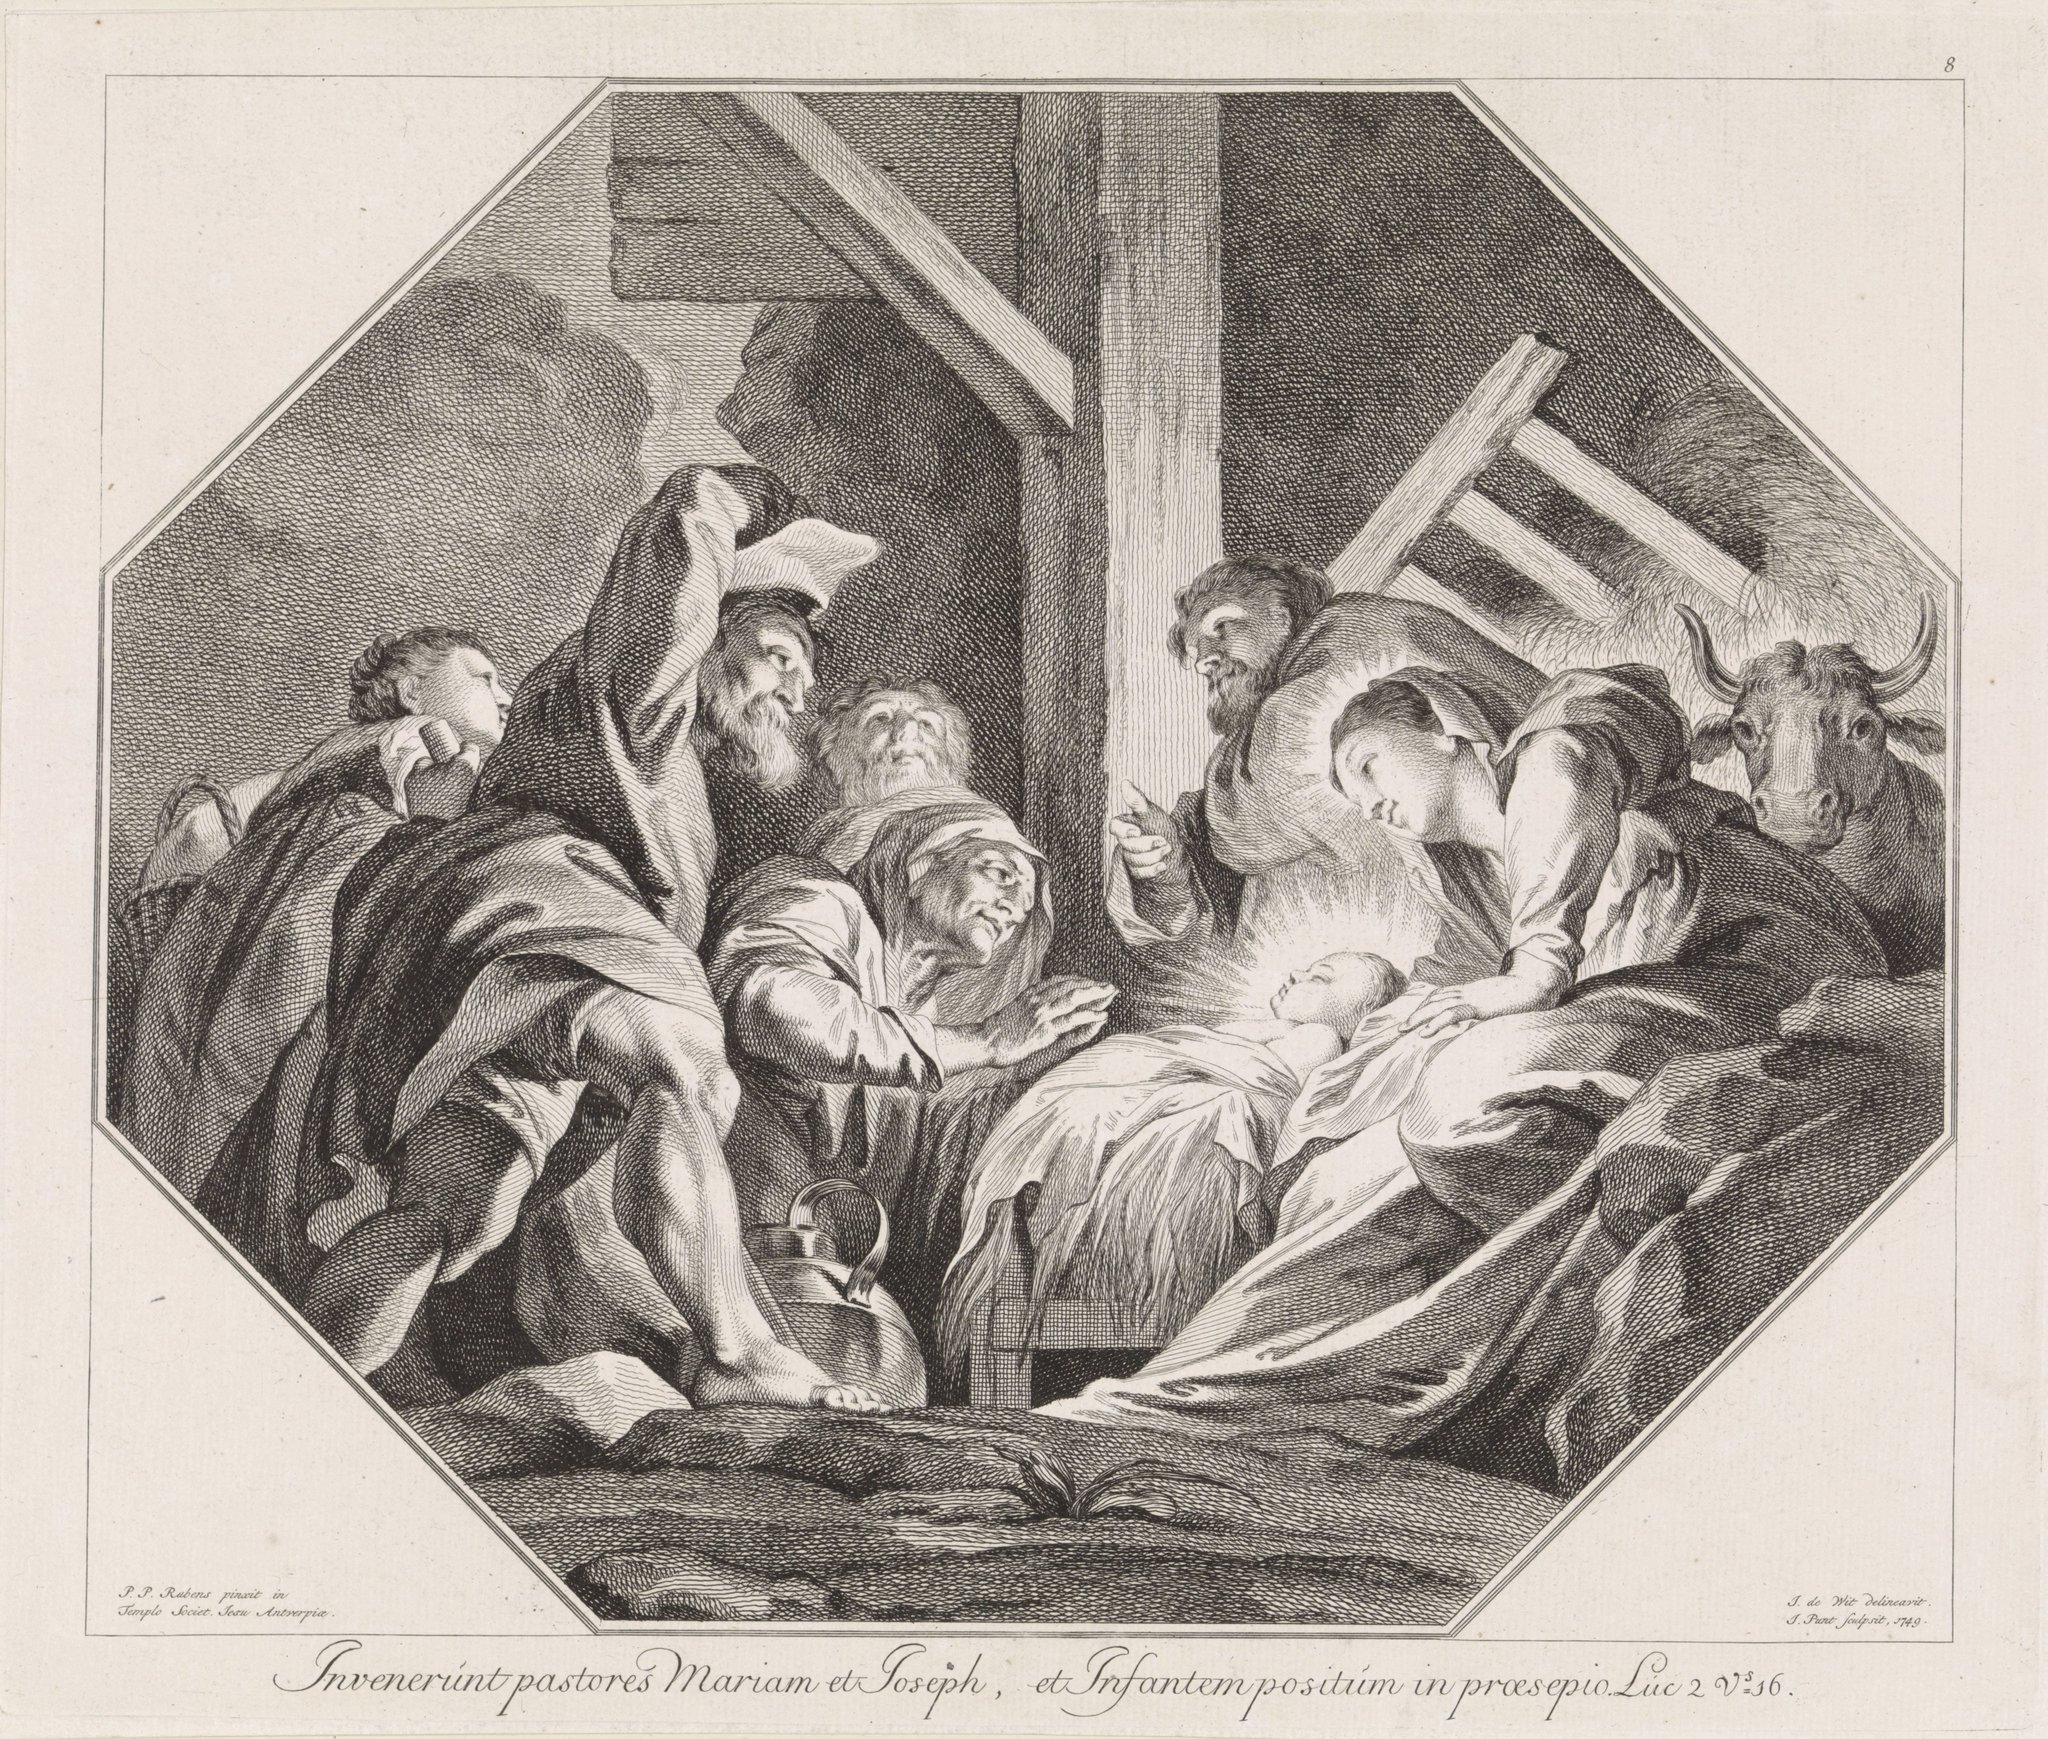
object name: print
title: Aanbidding door de herders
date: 1749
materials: paper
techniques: engraving, etching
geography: amsterdam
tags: adoration of the christ-child by the shepherds; mary and joseph present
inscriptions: collector's mark: Lugt 240, date: ‘1749’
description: Aanbidding door de herders. Onder de octagonale voorstelling een vers in het Latijn uit Luc. 2:16.